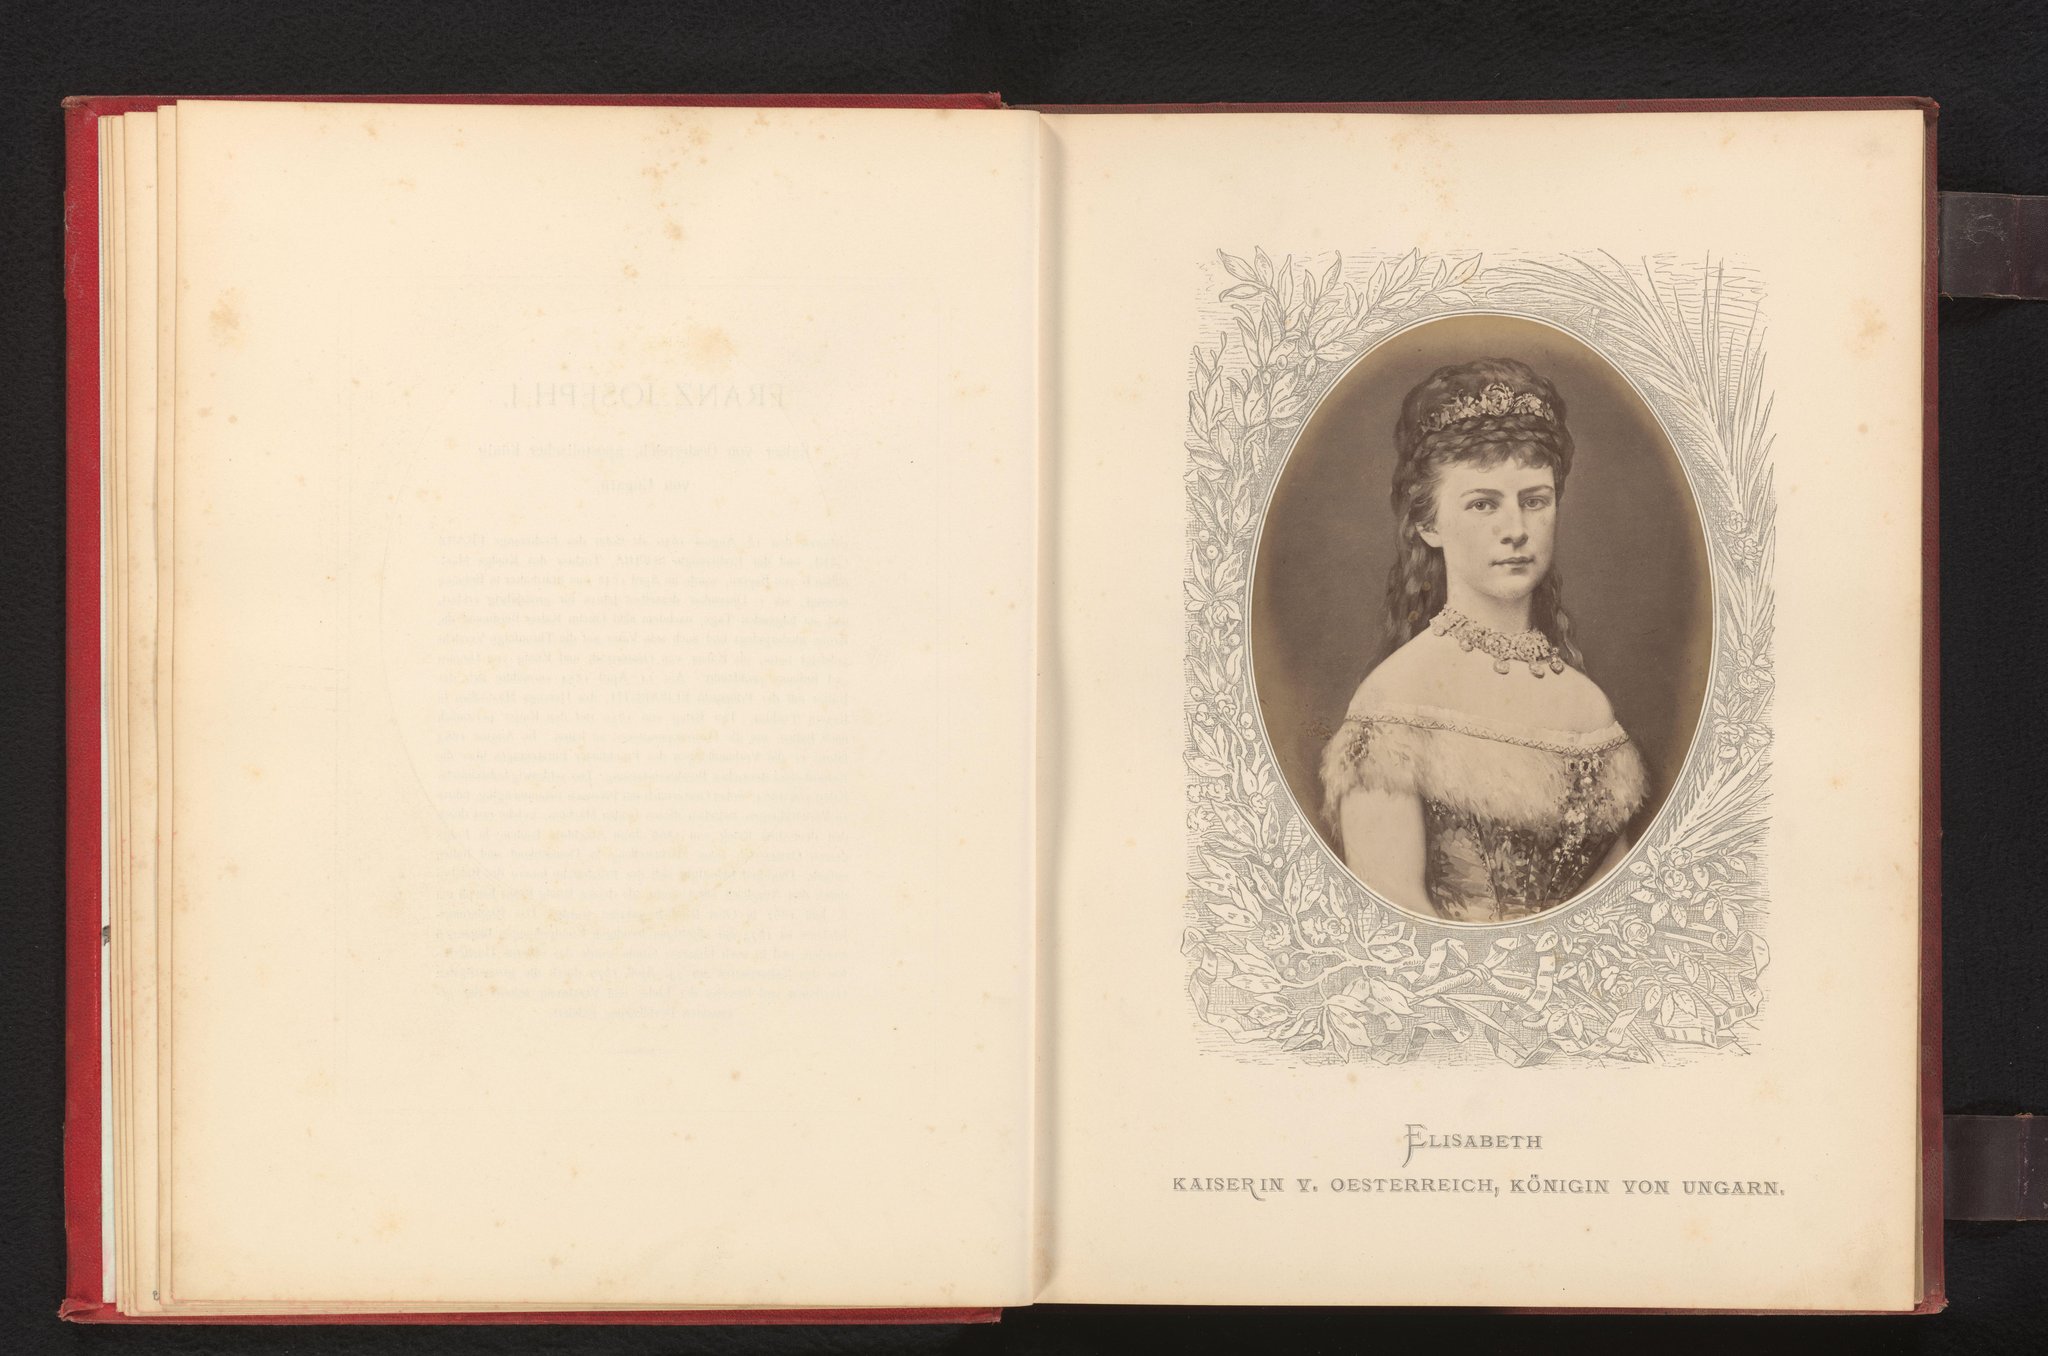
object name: page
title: Fotoreproductie van een geschilderd portret van Elisabeth, keizerin van Oostenrijk en koningin van Hongarije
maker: Anonymous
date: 1875-1880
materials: paper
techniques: albumen print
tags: historical persons - bb - woman, queen, empress, etc. (wife of a ruler)